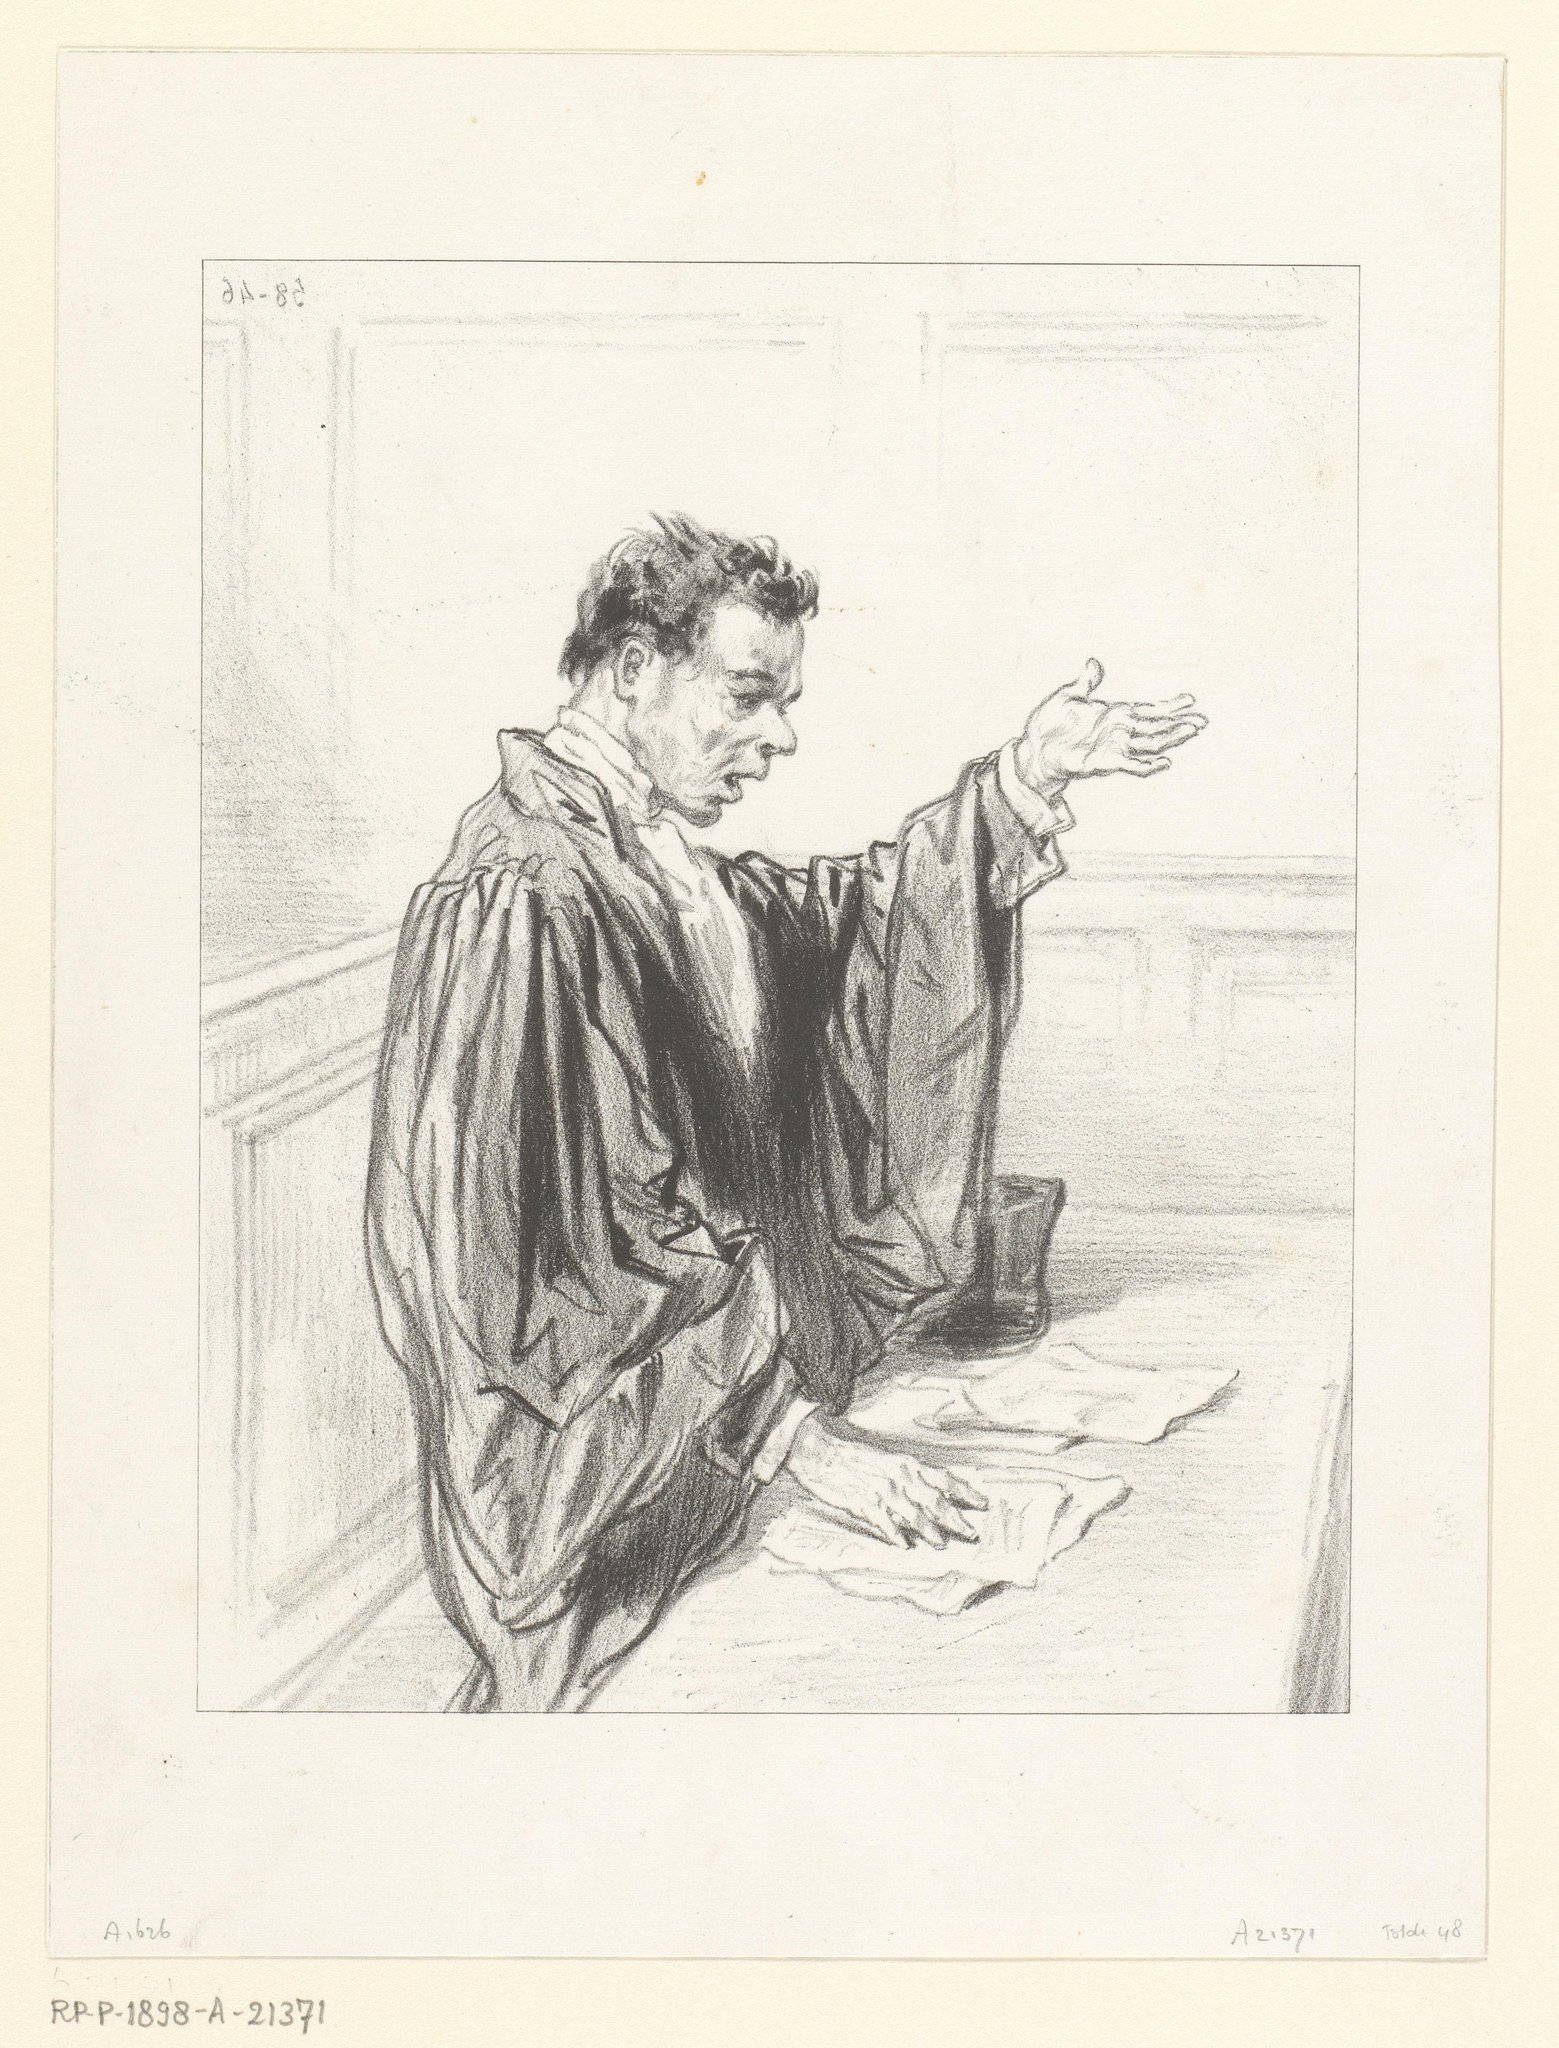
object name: print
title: Les Toquades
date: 1858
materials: paper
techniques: lithograph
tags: plea, defence